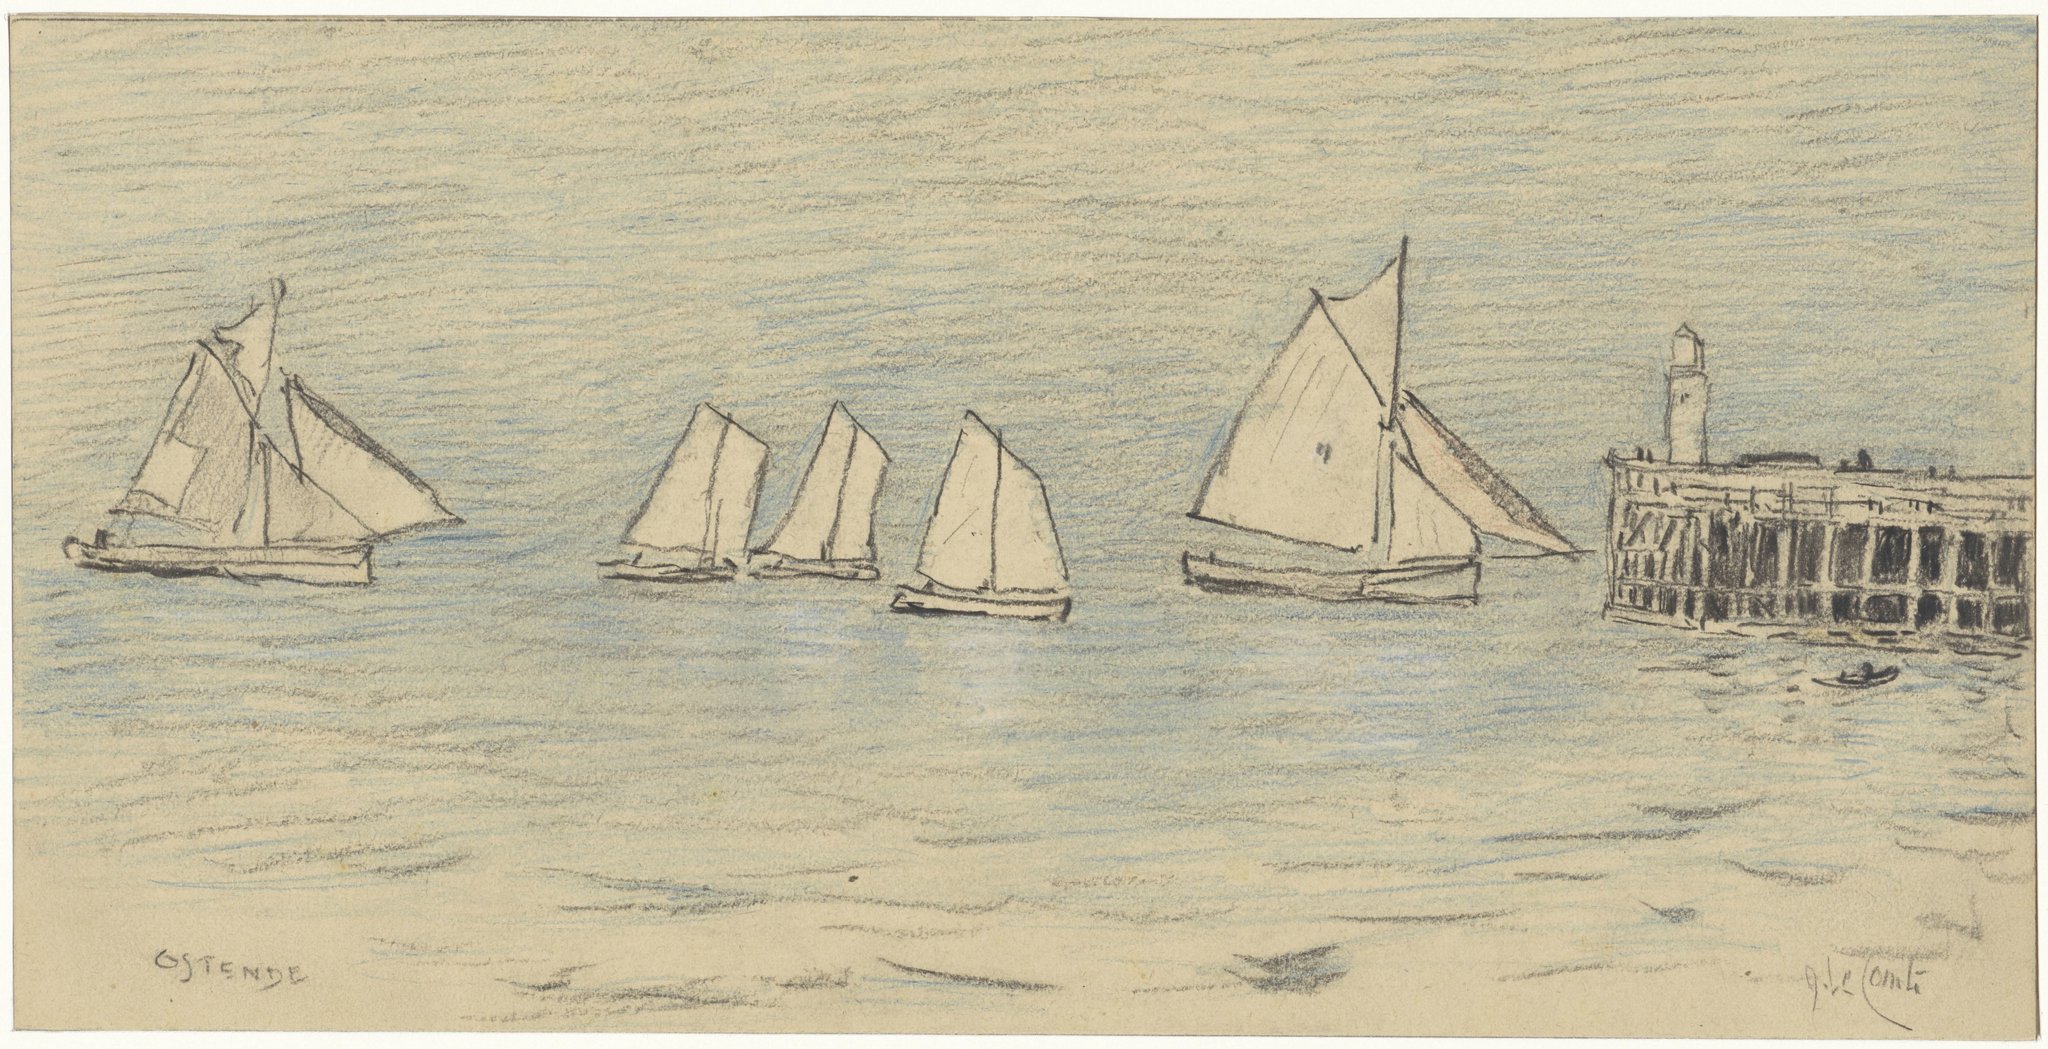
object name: drawing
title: Zeilschepen bij de steiger van Oostende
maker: adolf le comte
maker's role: draughtsman, painter, print maker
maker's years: 1850-1921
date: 1860-1921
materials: chalk, paper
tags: pier, quay, wharf, belgium